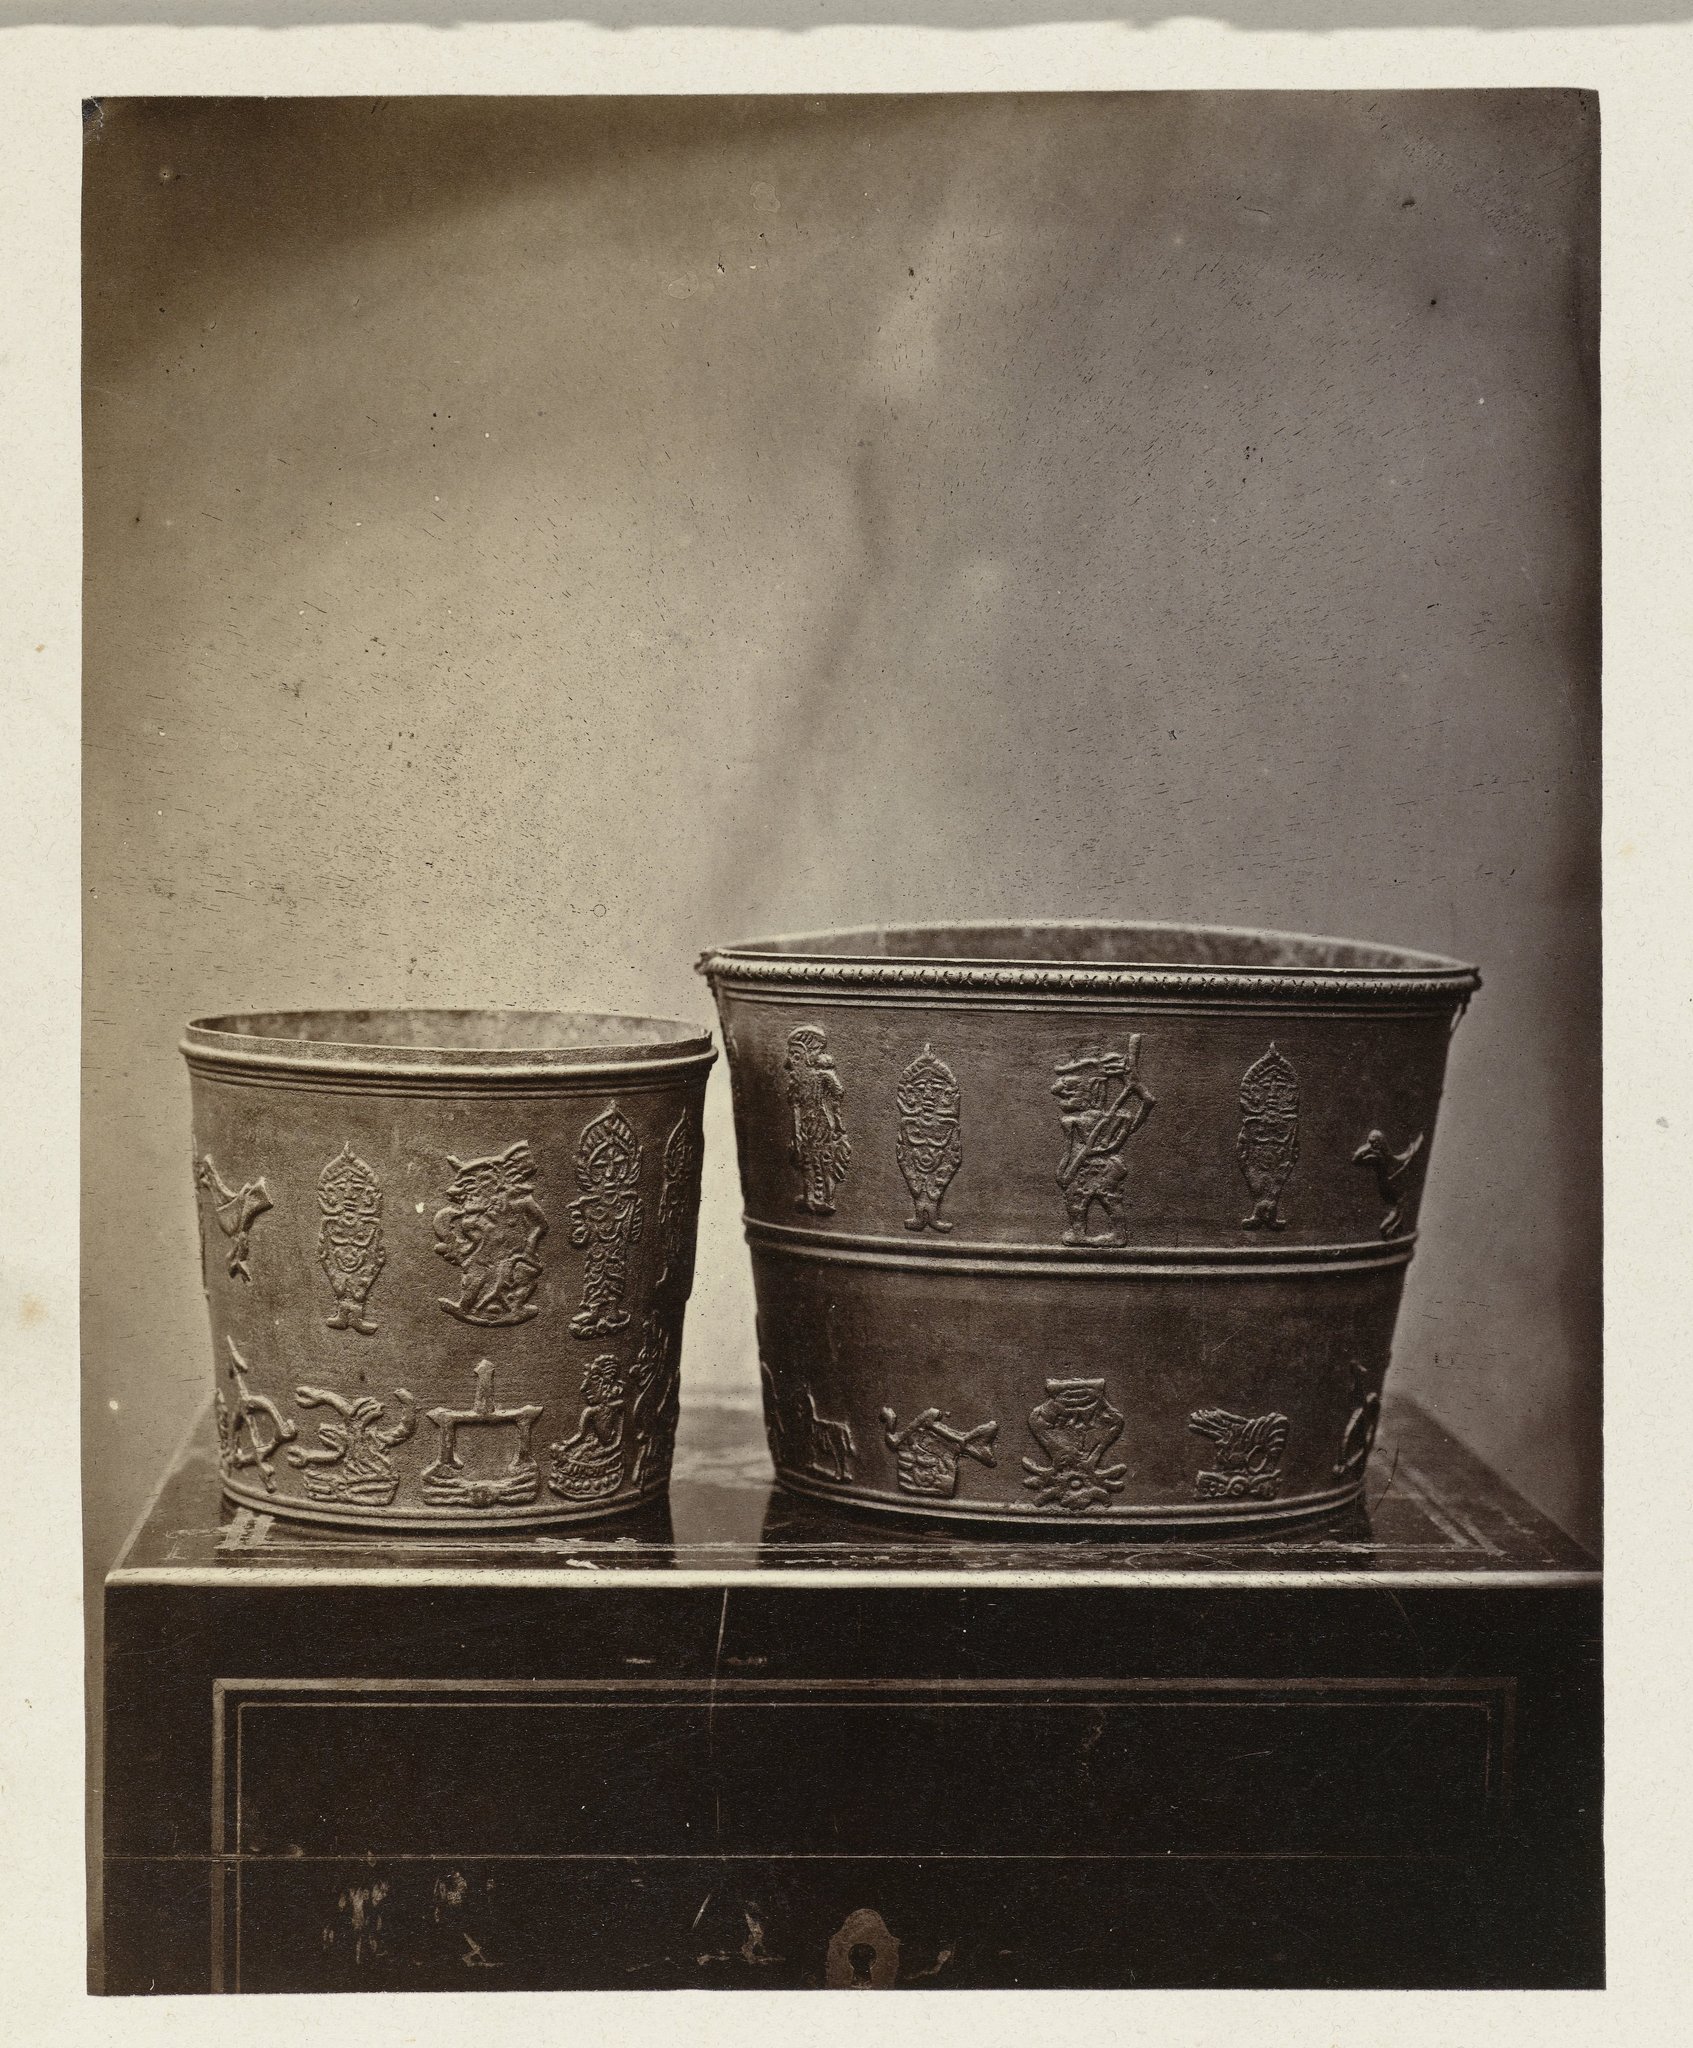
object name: photograph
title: Two Zodiac jugs. Kawali, Ciamis district, West Java privonce, 14th-16th century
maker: isidore kinsbergen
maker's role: fotograaf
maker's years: 1821-1905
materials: cardboard, paper, photographic support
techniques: albumen print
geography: java